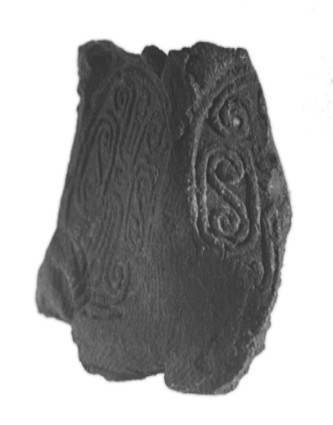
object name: sealing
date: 2030-1640 BCE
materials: clay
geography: egypt